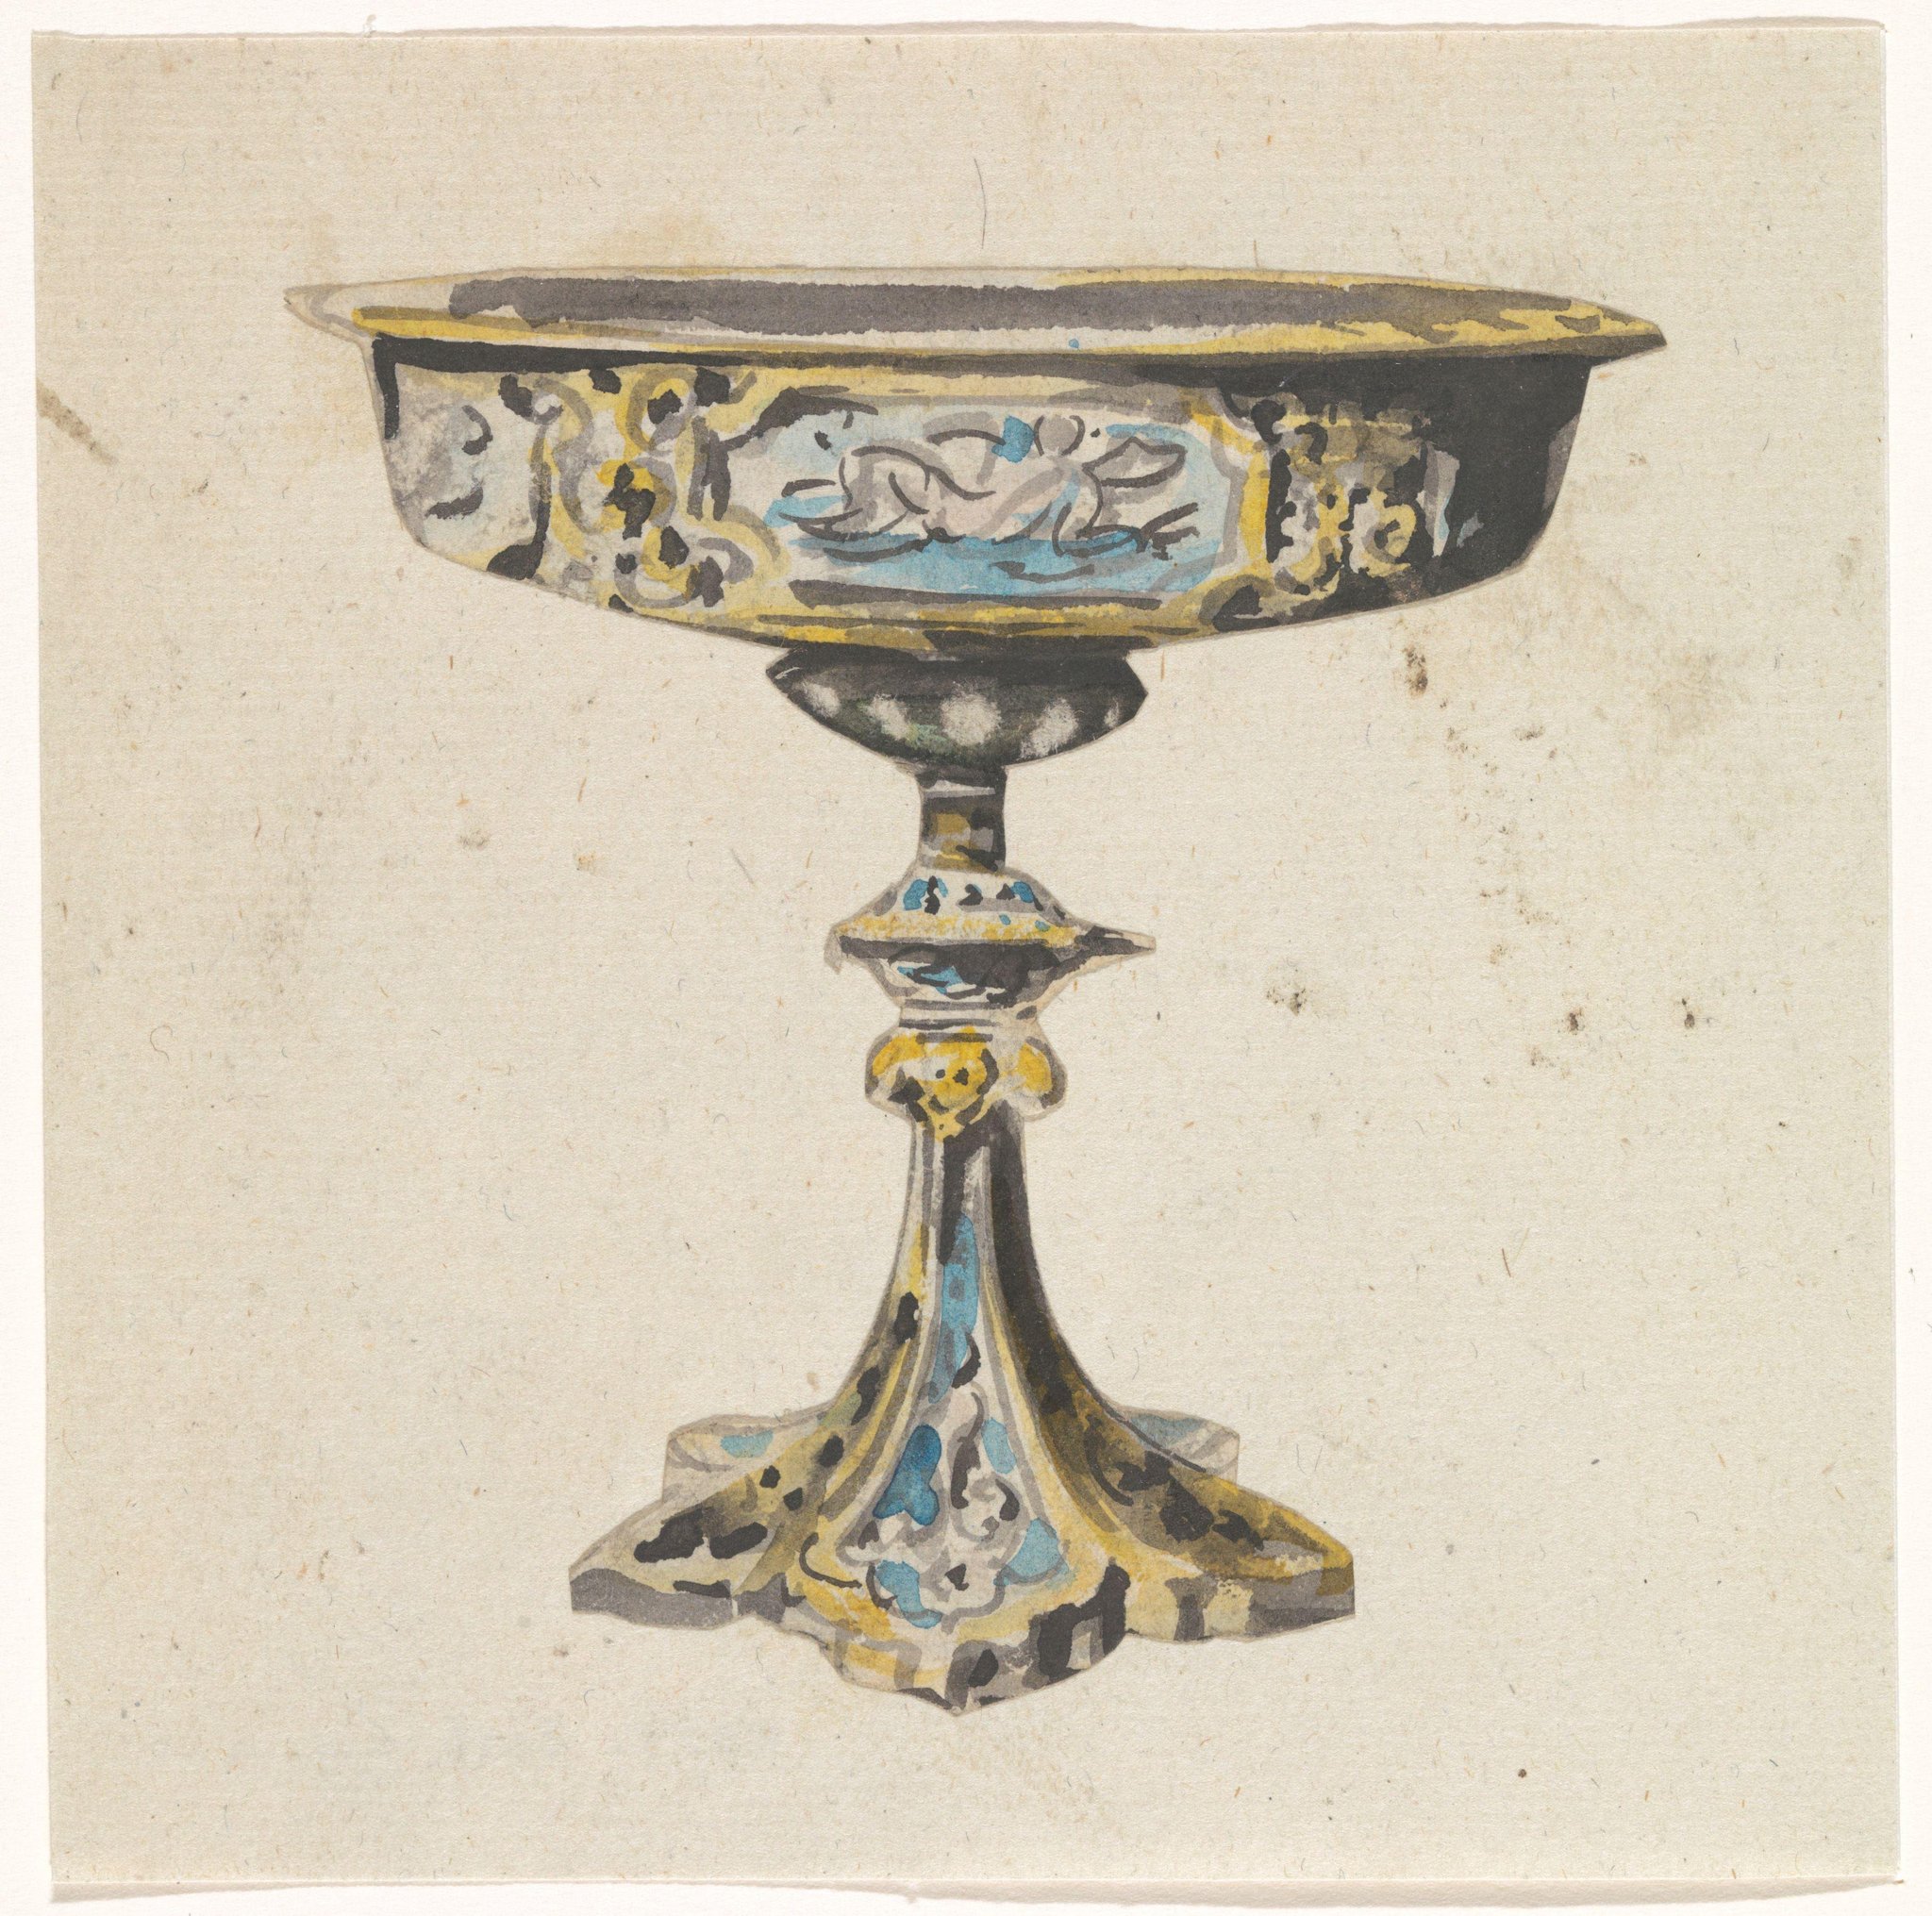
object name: design drawing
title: Geëmailleerde coupe op een zespasvoet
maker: Anonymous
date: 1840-1860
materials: graphite, paper, watercolor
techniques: aquarelle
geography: france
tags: containers, laid table: table-ware, table-decoration, etc.